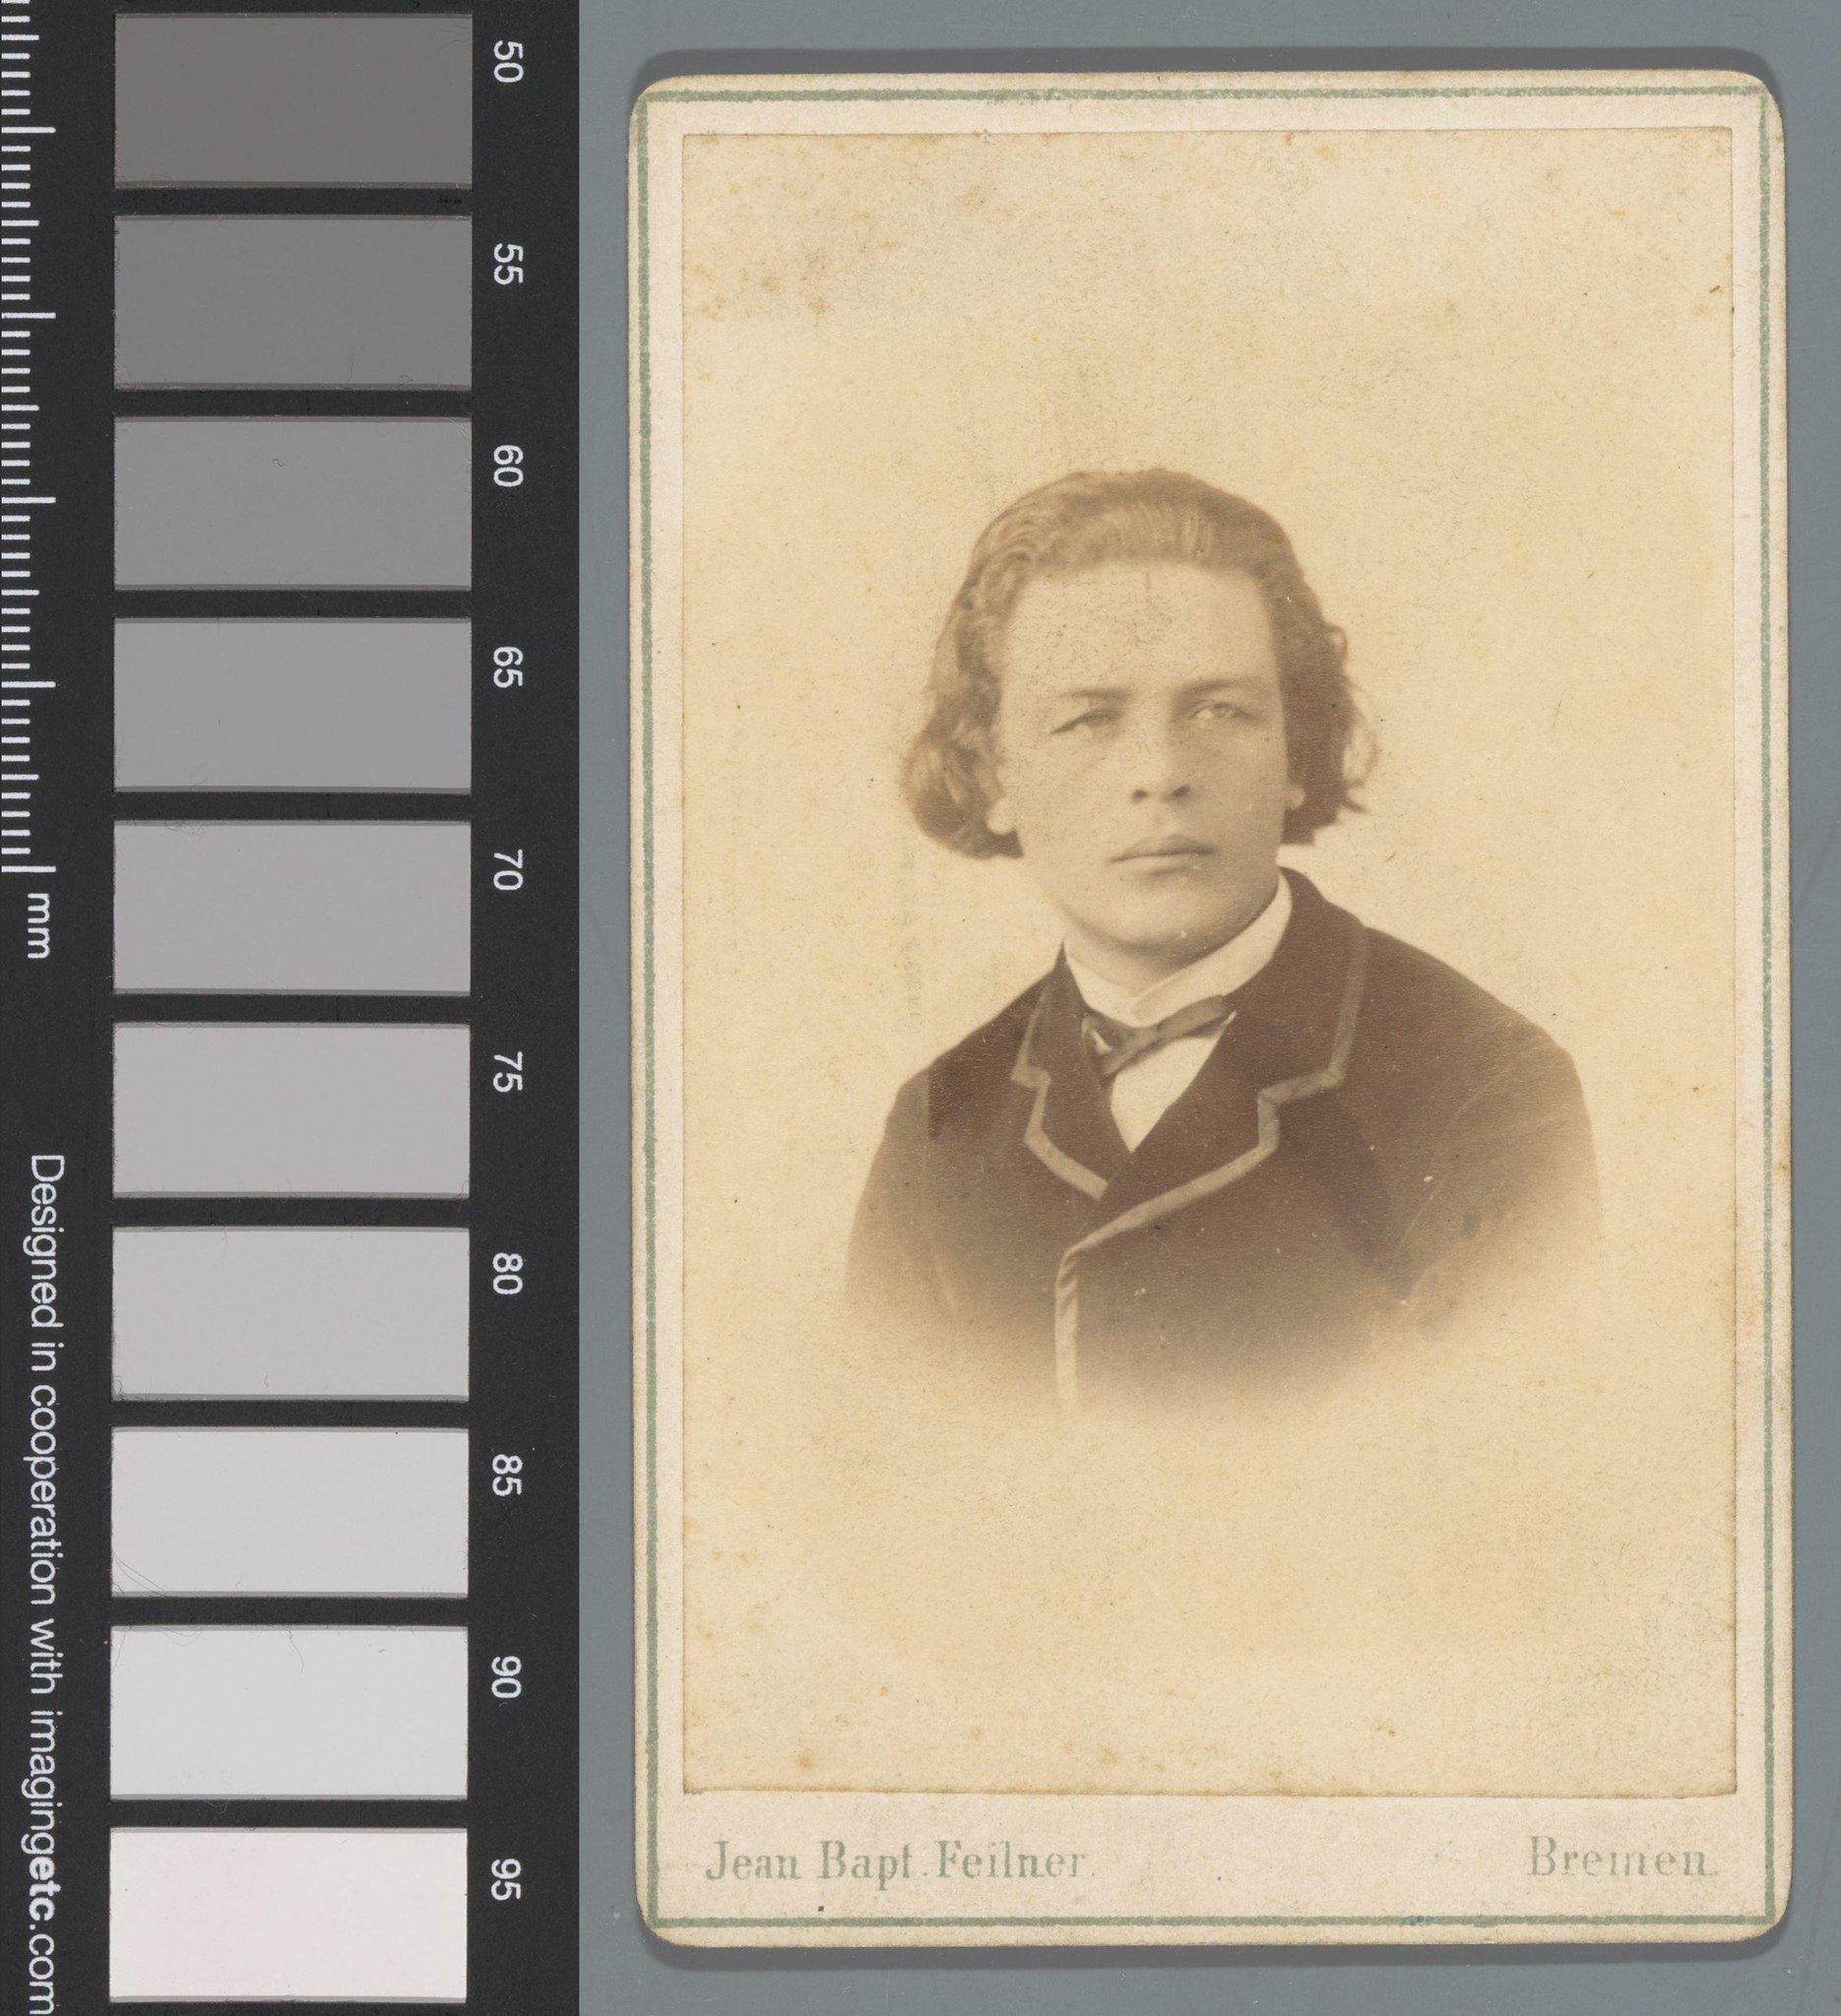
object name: photograph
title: Portret van componist en pianist Anton Grigorevich Rubinstein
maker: jean baptiste feilner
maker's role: fotograaf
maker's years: 1844-1912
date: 1854-1859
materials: cardboard, paper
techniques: albumen print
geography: bremen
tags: adult man, historical persons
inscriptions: inscription: ‘Jean Baptiste Feilner/ Photograph/ Bremen Wall No. 154./ Die Platte wird zum nachbestellen aufbewahrt.’, inscription: ‘Jean Bapt. Feilner Bremen.’